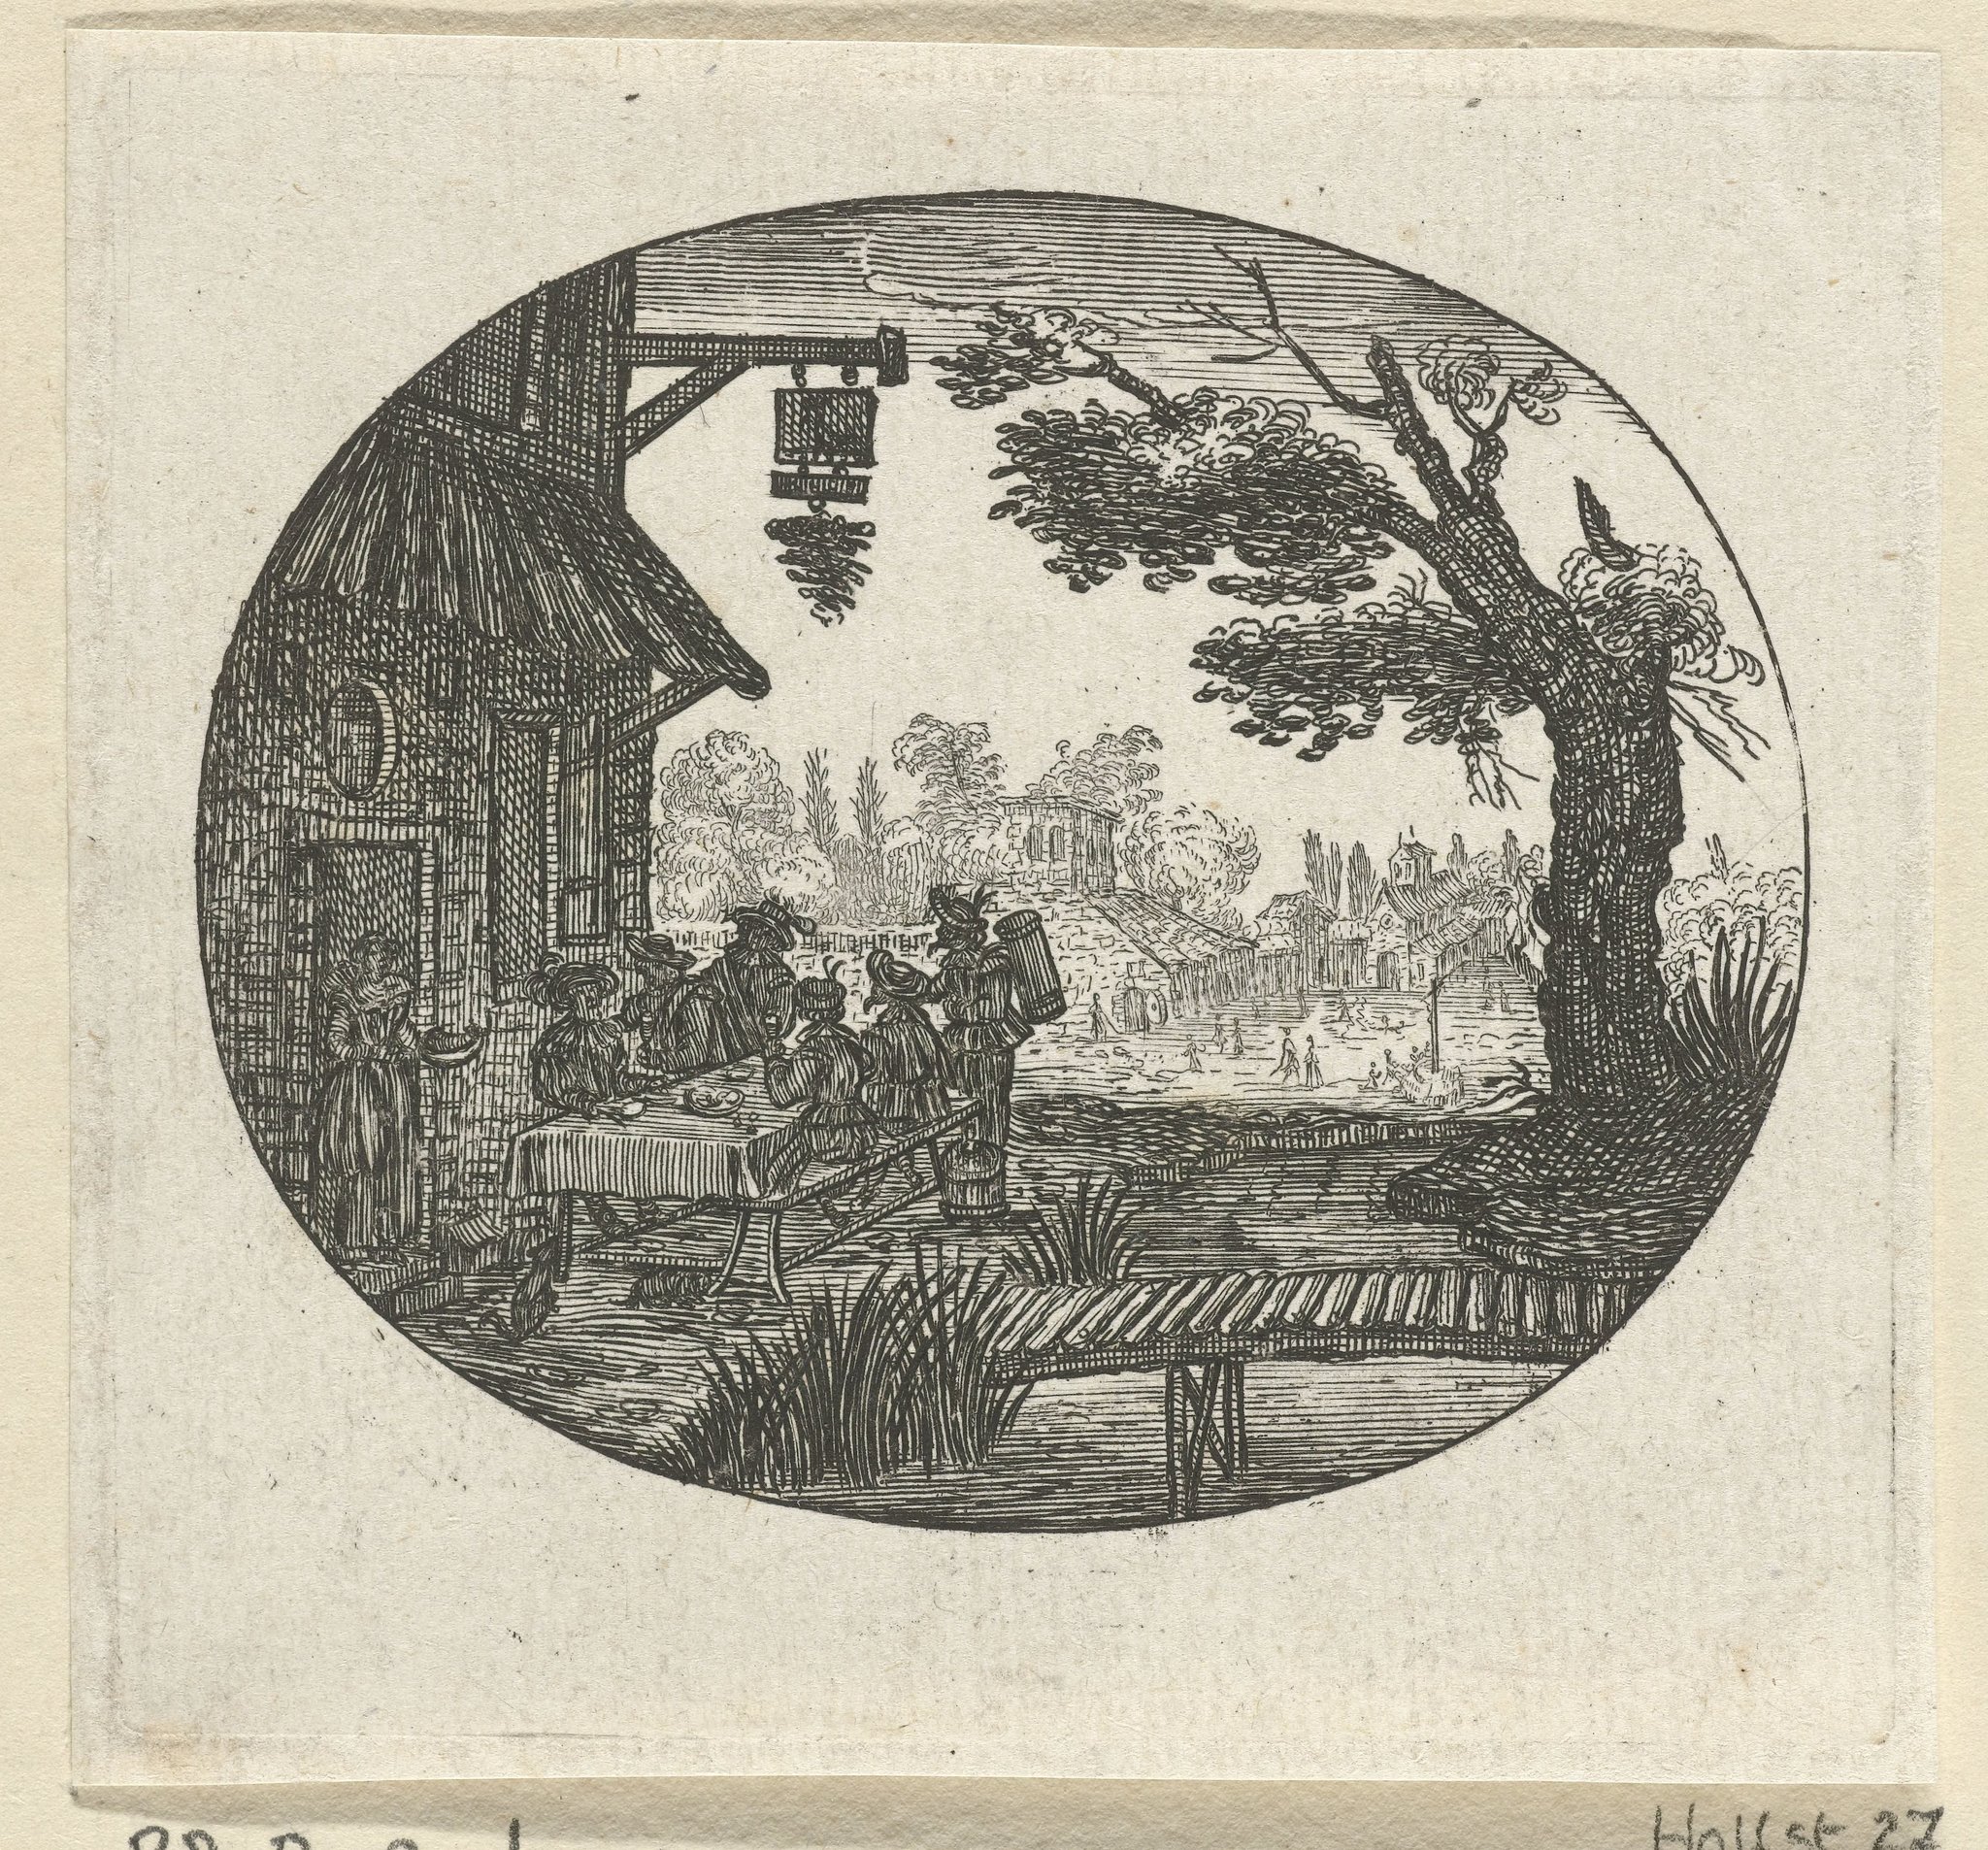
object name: print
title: Landschappen in ovalen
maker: chaerles de hooch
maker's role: painter, print maker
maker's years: 1600-1638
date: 1613-1638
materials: paper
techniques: engraving, etching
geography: northern netherlands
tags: table, landscapes (+ landscape with figures, staffage), hotel, hostelry, inn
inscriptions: collector's mark: Lugt 240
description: Een landschap met een gezelschap aan een tafel voor een herberg, een dorp op de achtergrond. Prent uit een serie van acht met voorstellingen van landschappen, alle in een ovaal.